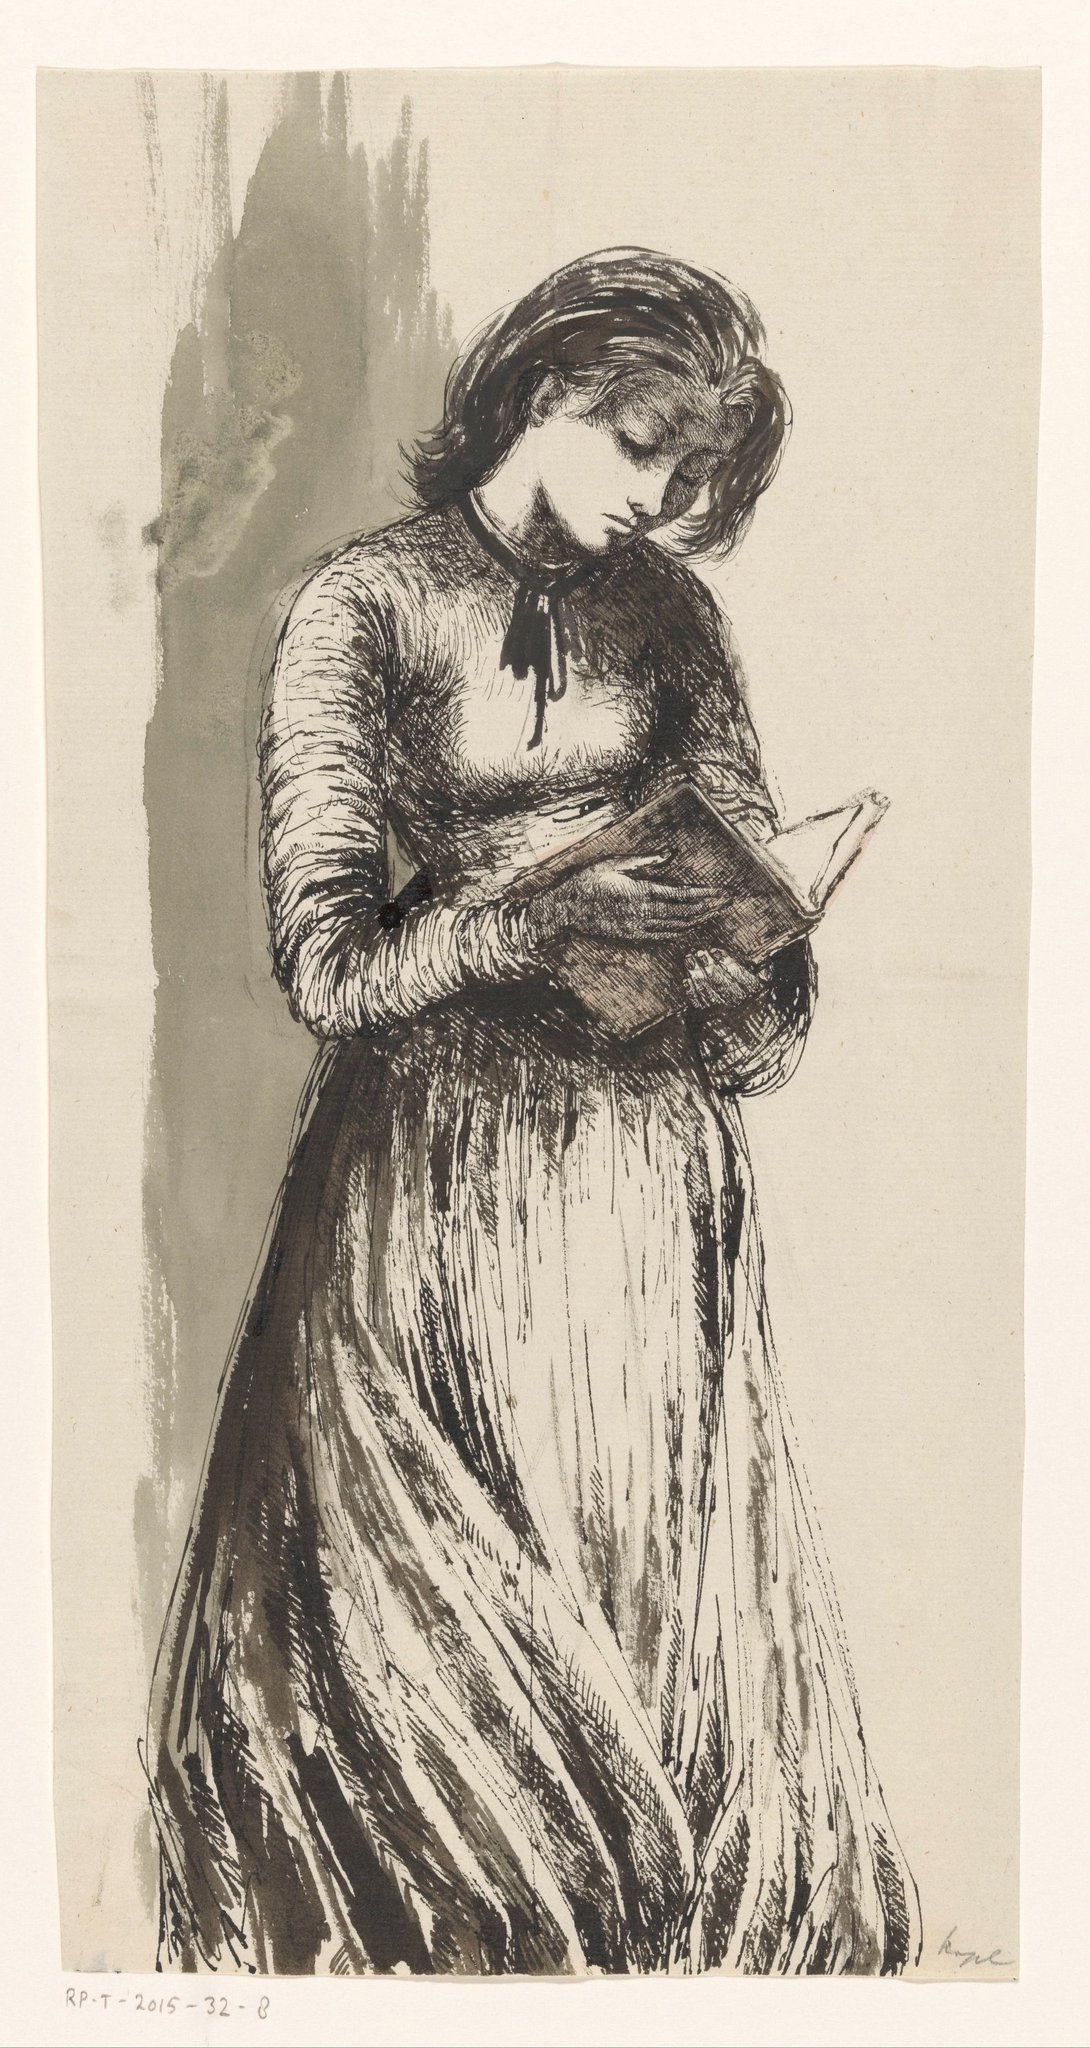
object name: drawing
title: Lezende jonge vrouw met een opengeslagen boek in haar handen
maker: Anonymous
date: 1850-1900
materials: ink, paper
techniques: brush, pen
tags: reading, book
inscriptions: collector's mark: Lugt 2228, watermark